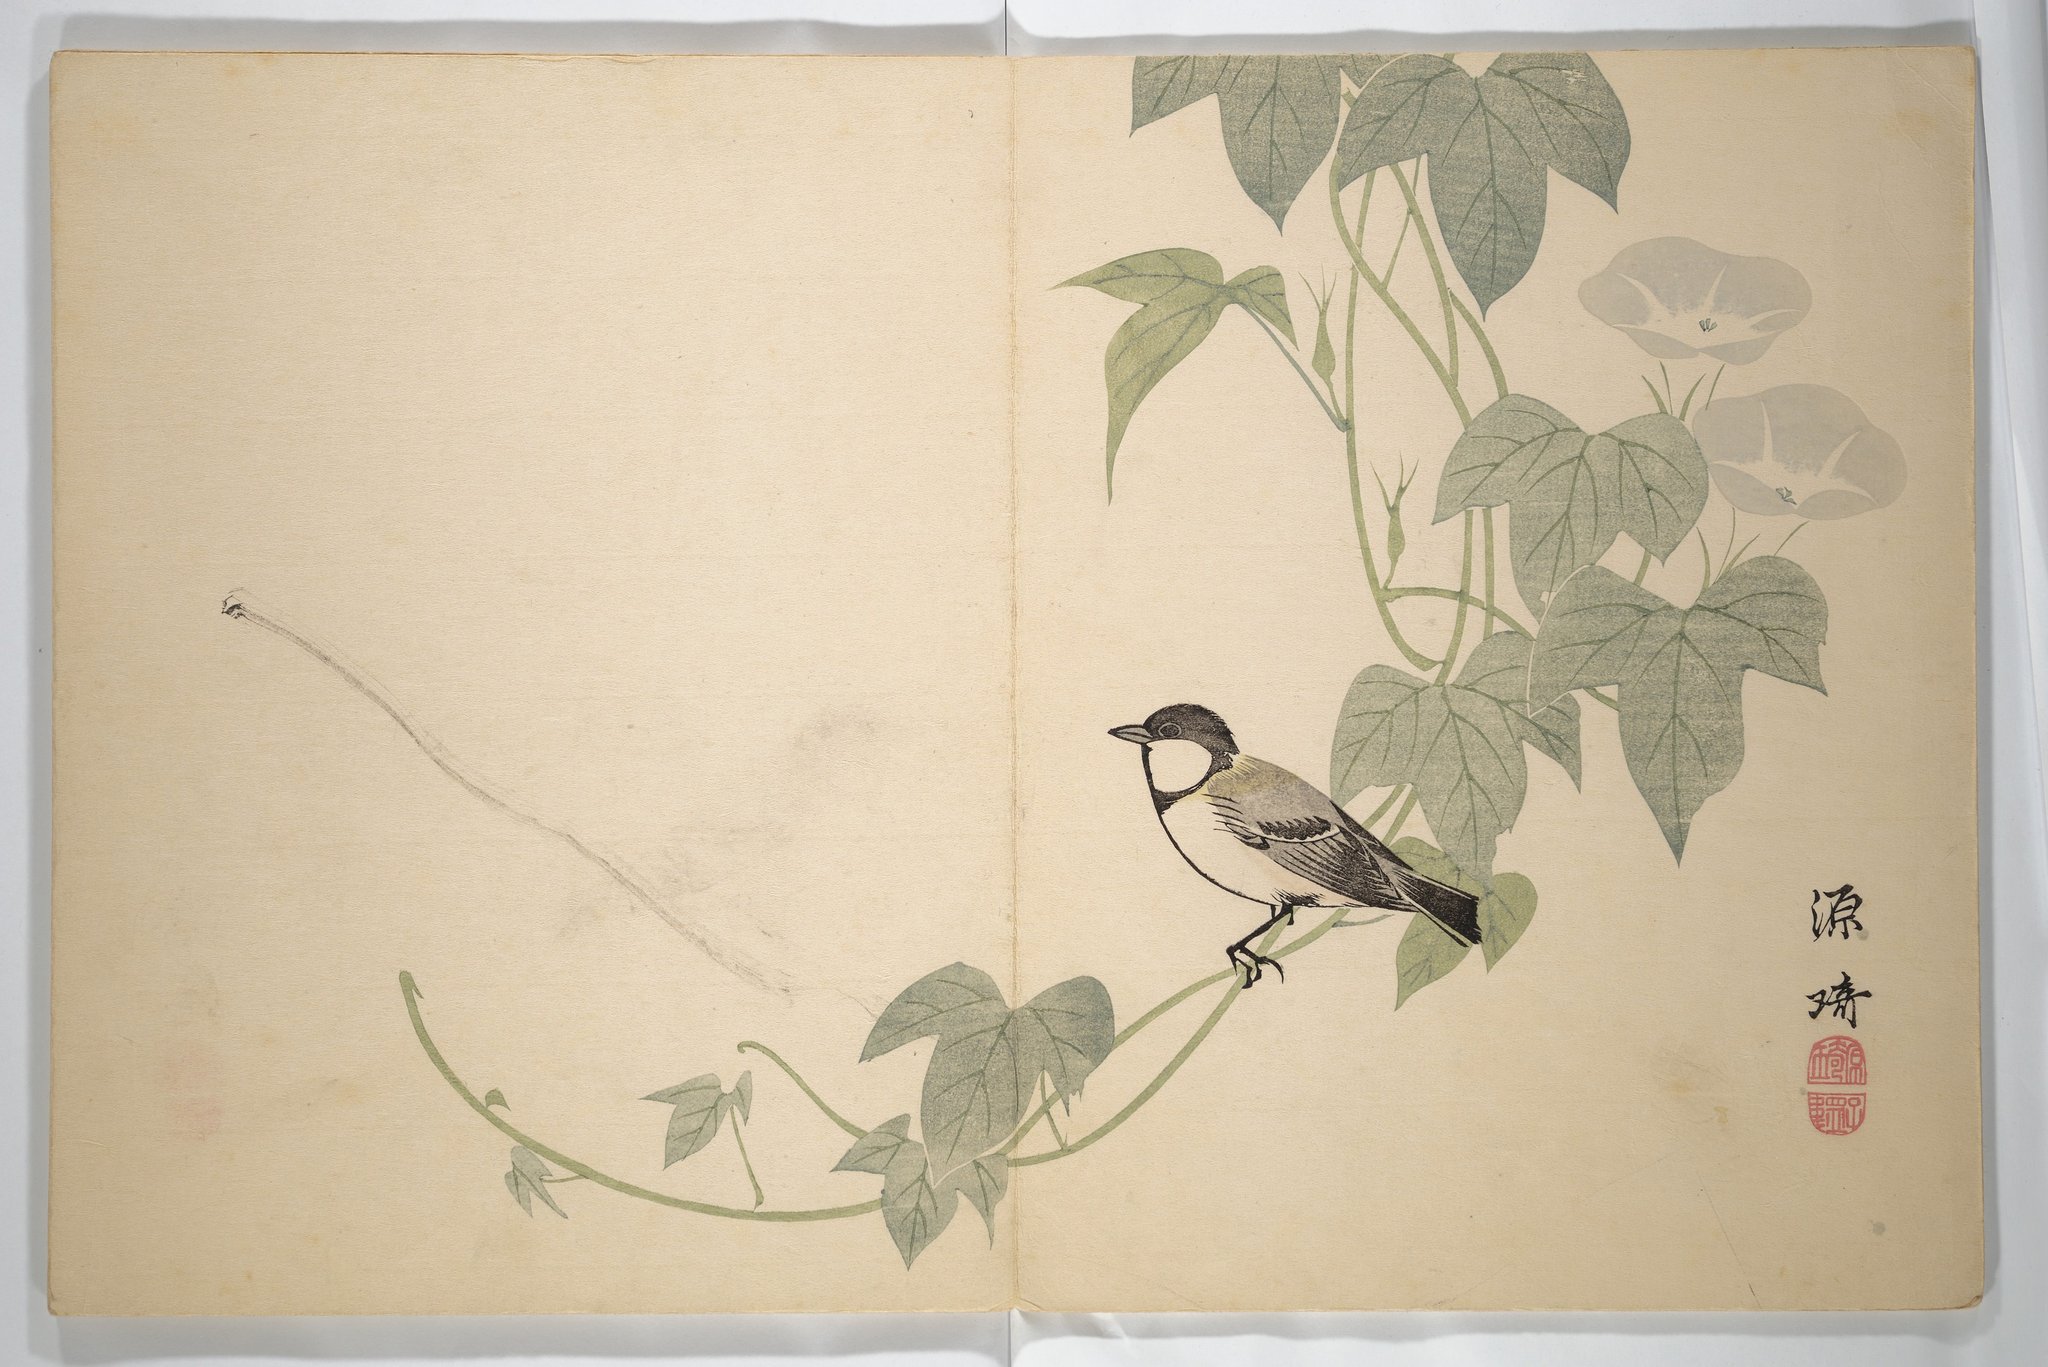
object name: illustrated book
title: Collected Haiku Poems (Hokku shū) 発句集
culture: japanese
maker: genki 源琦 (komai ki 駒井琦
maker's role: artist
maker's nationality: japanese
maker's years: 1747-1797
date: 1793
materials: ink, paper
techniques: woodblock print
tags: birds,poetry